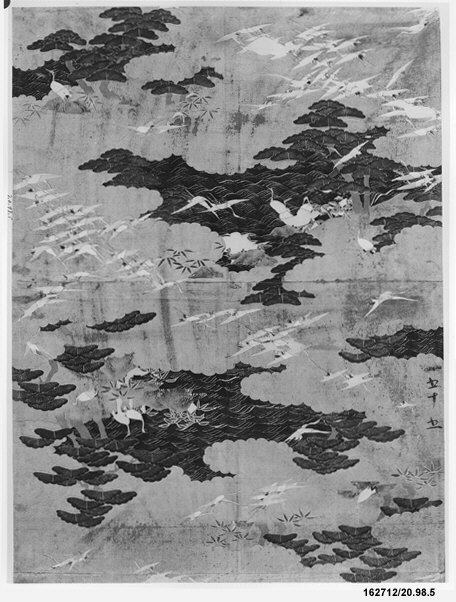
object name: textile design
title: Textile Design for Stencil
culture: japanese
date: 1601-1700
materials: paint, paper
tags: birds